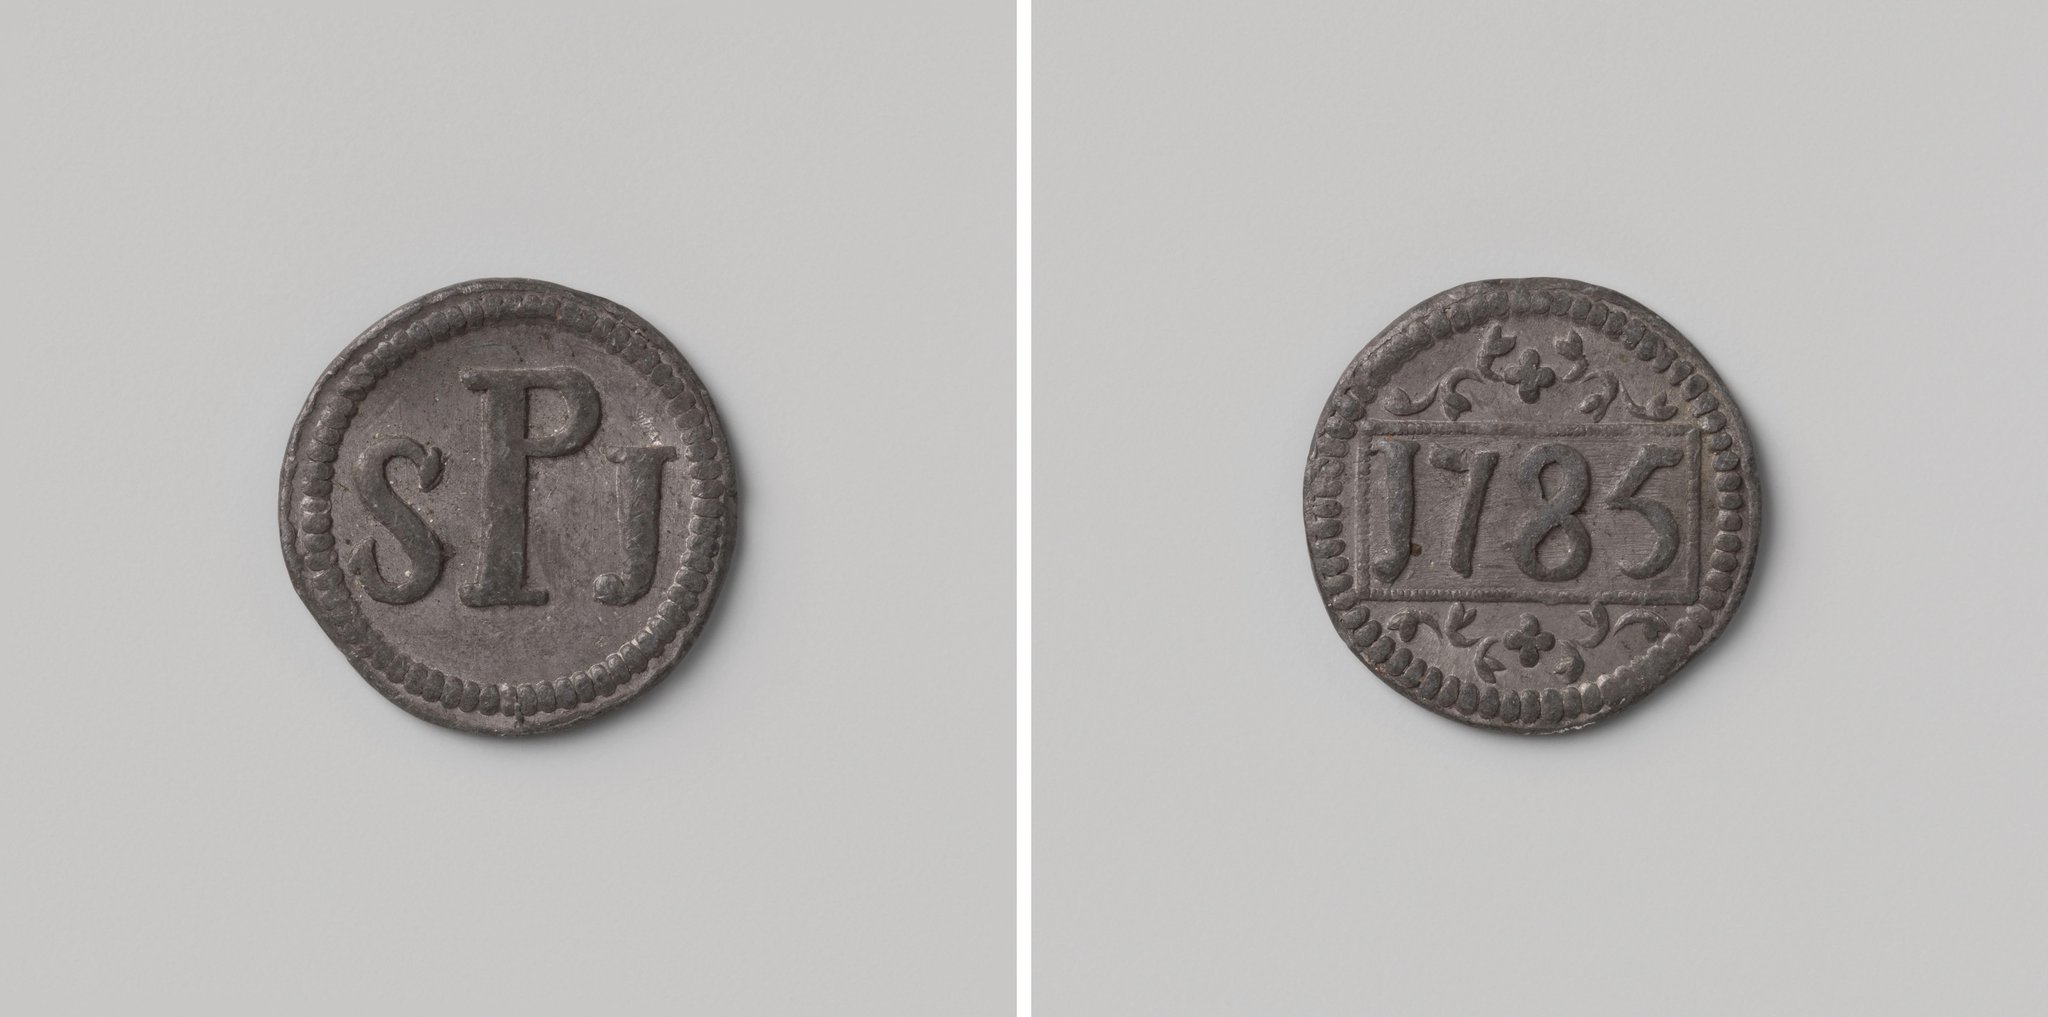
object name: medal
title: Penning met opschrift SPJ en 1785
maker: Anonymous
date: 1785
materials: lead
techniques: striking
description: Loden penning. Voorzijde: grote letter P, temidden van kleinere S en J binnen parelrand. Keerzijde: jaartal in compartiment; boven en onder bladversiering binnen parelrand